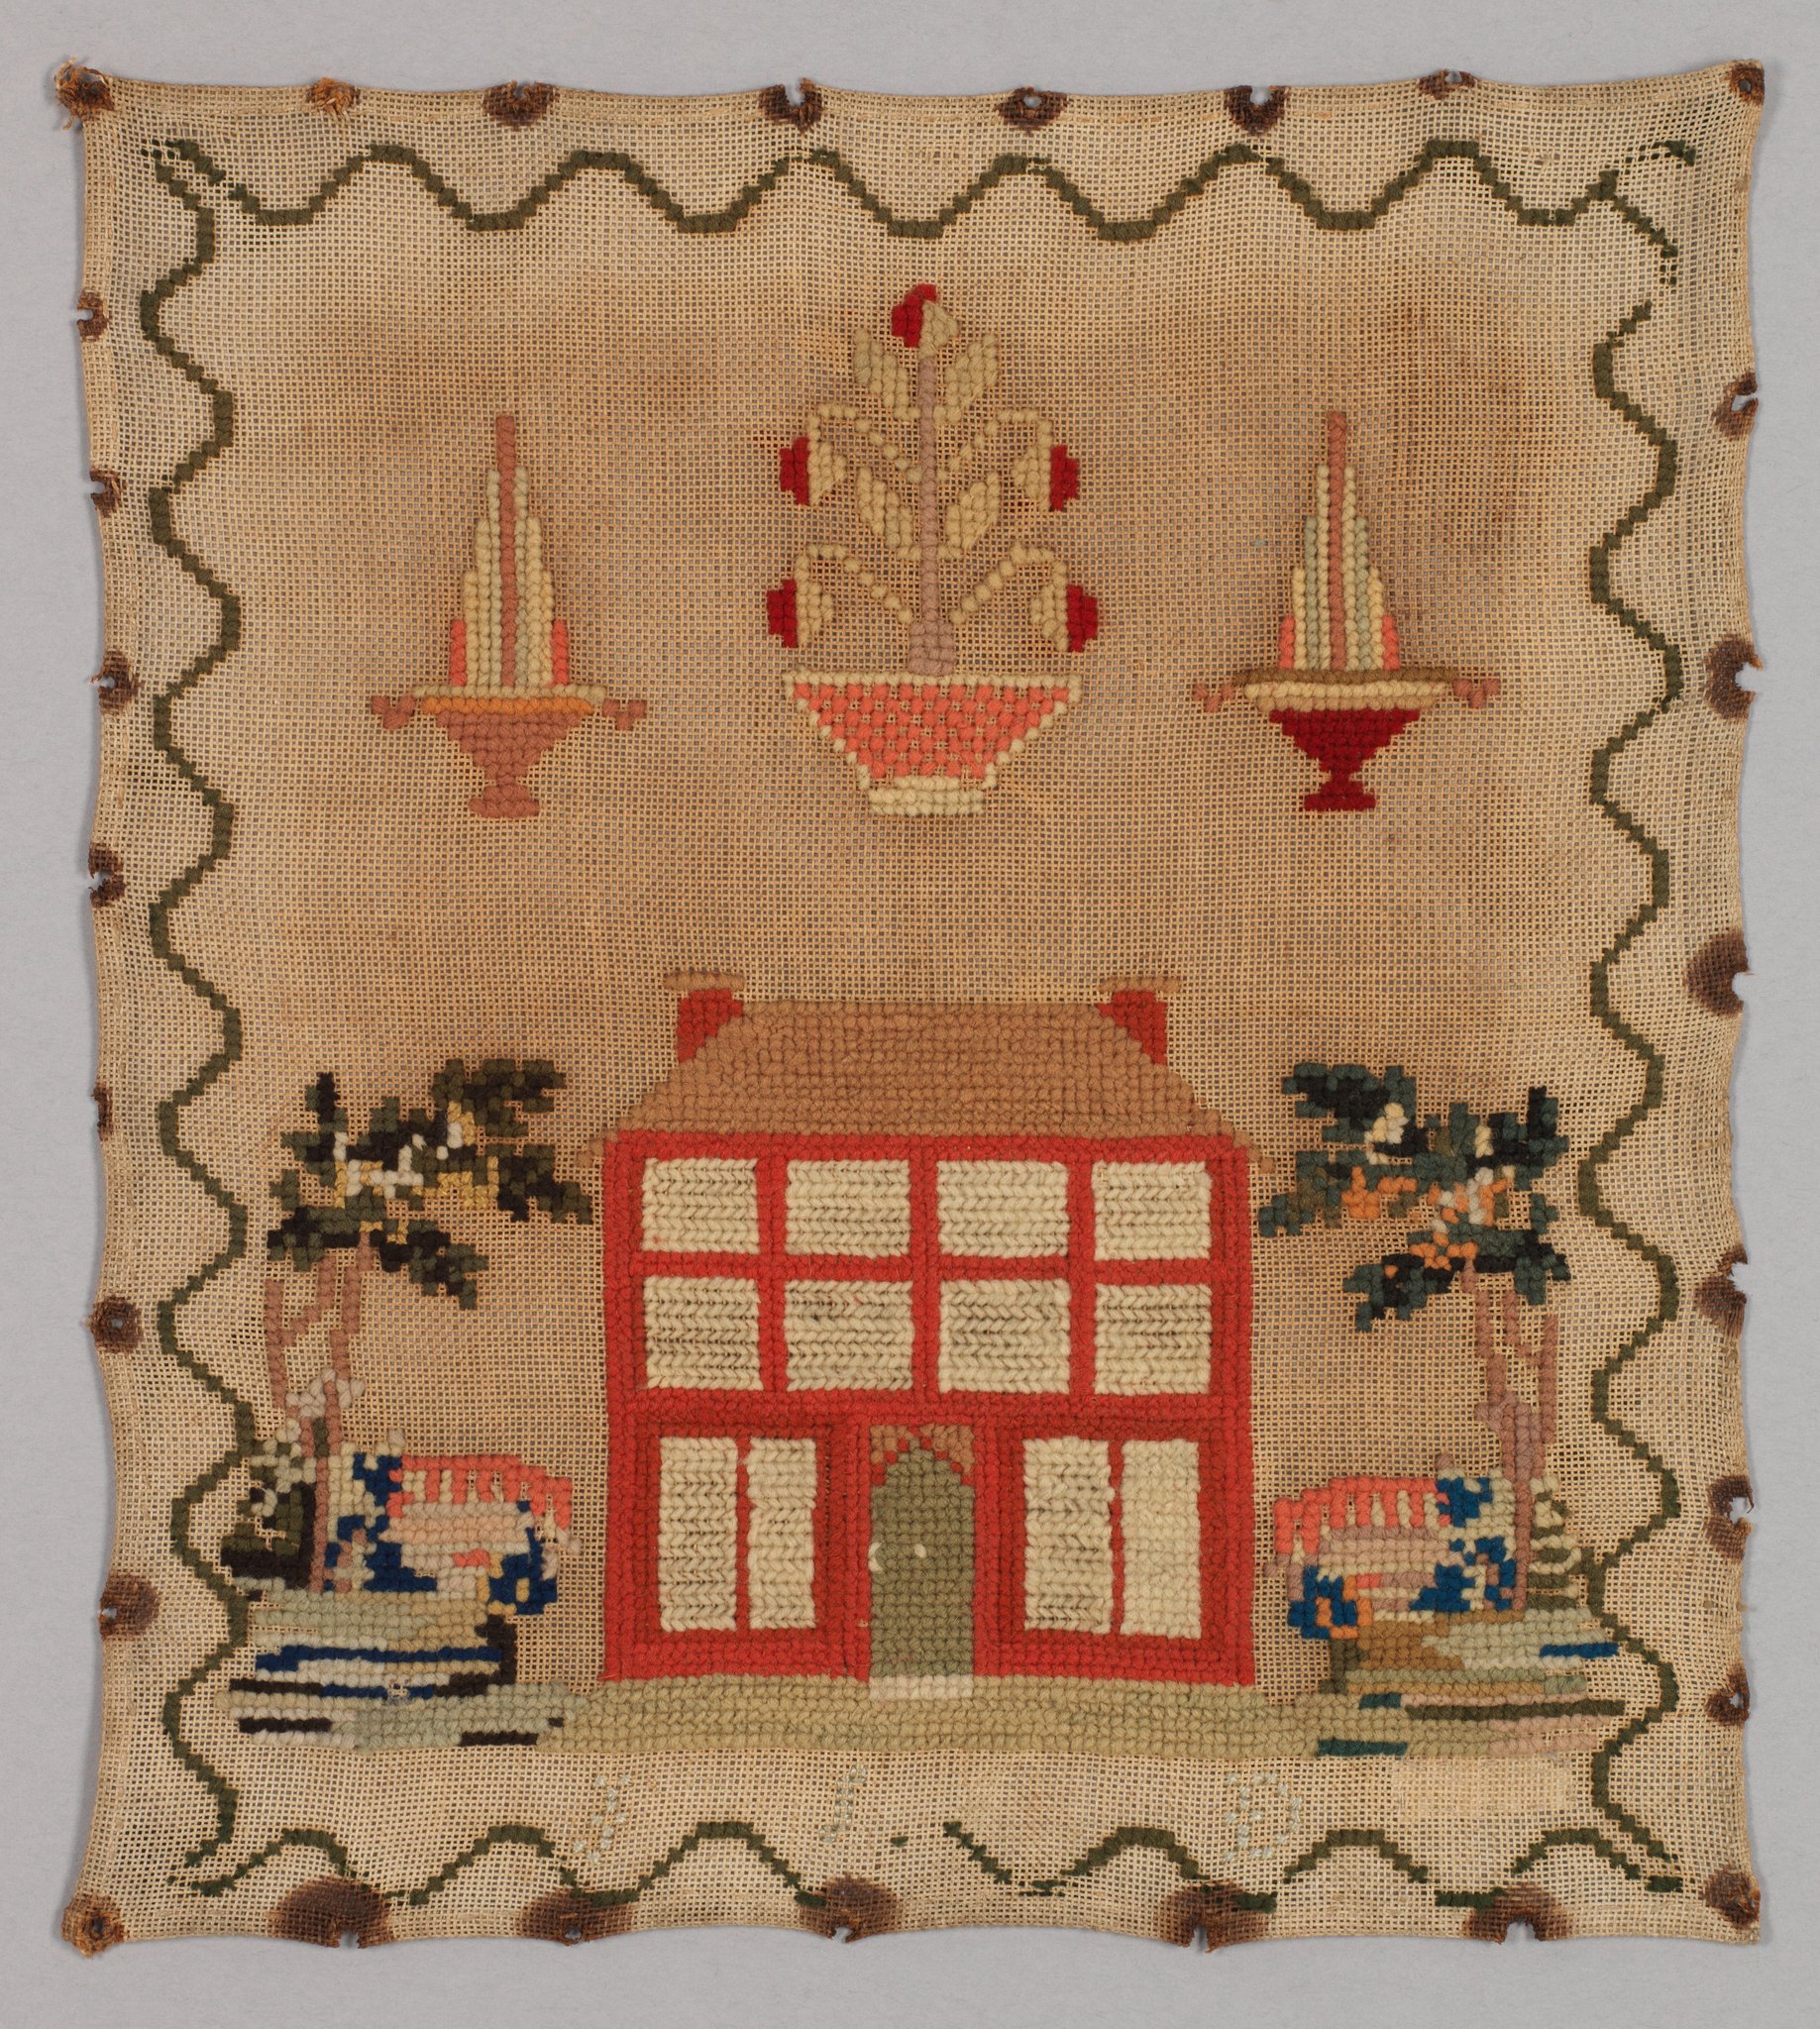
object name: sampler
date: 1801-1900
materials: canvas, linen, silk, wool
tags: houses,trees